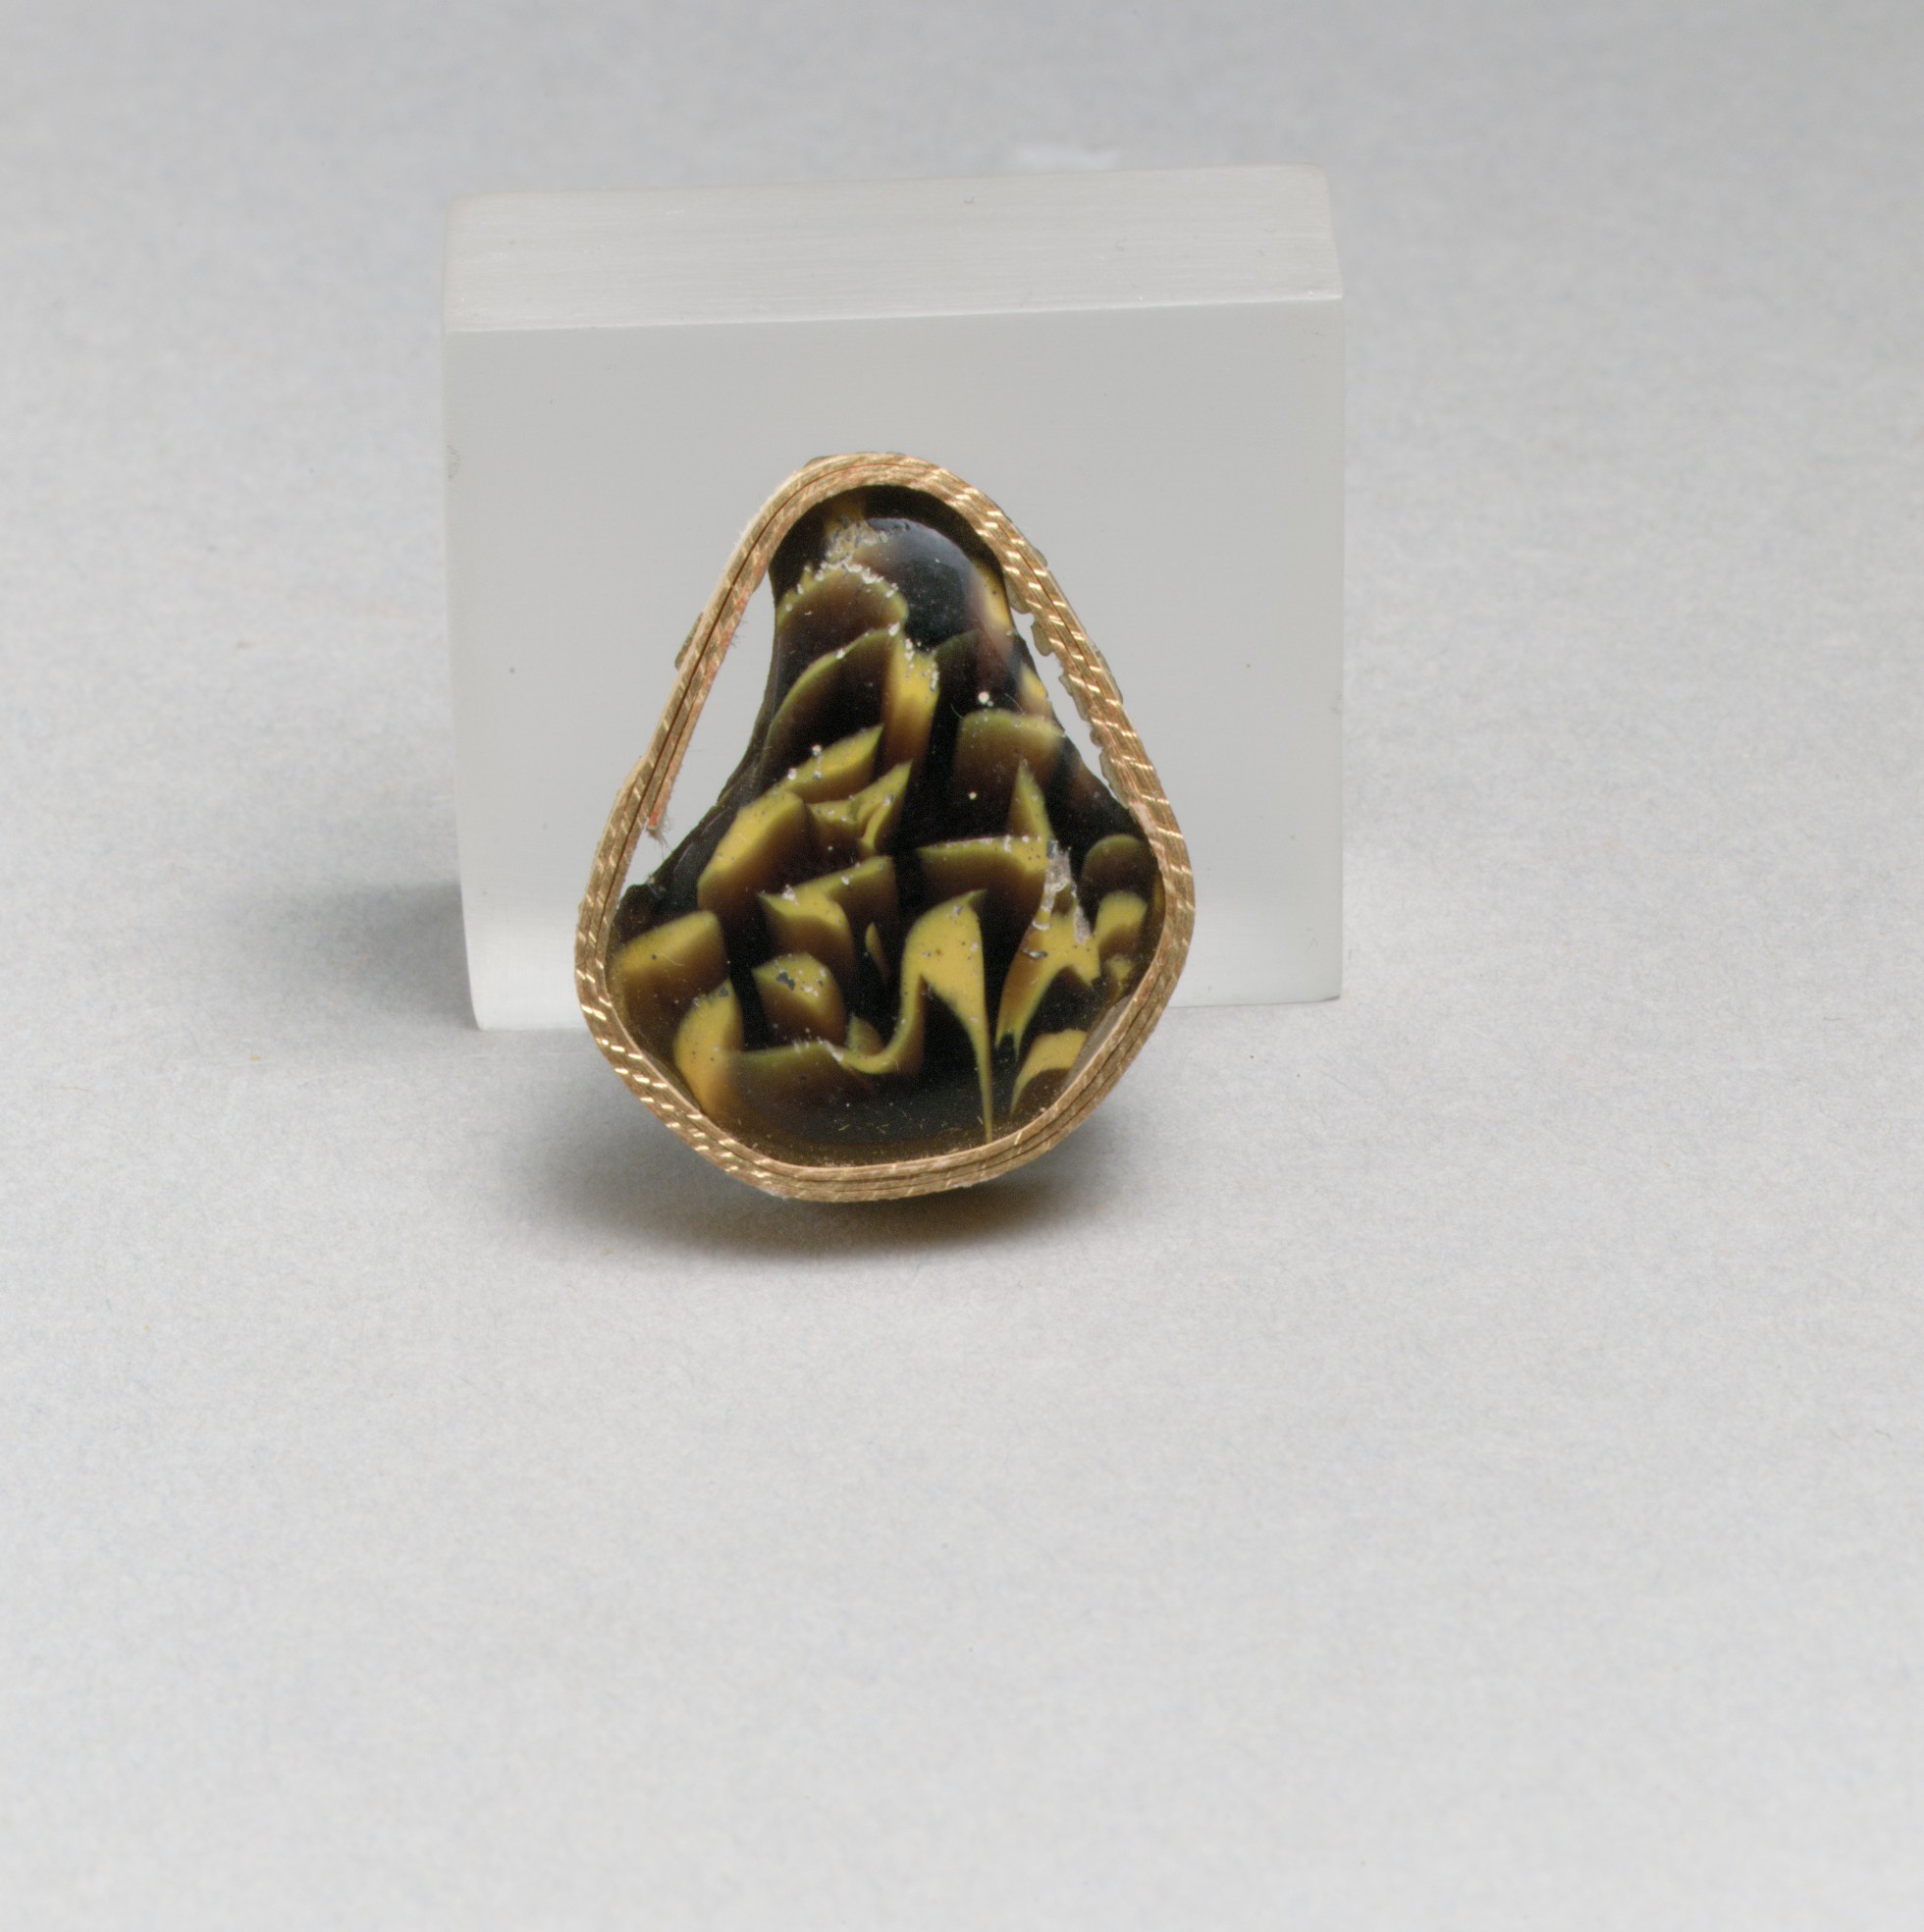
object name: fragment, mosaic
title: Glass mosaic fragment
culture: roman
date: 34 BCE-33 CE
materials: glass